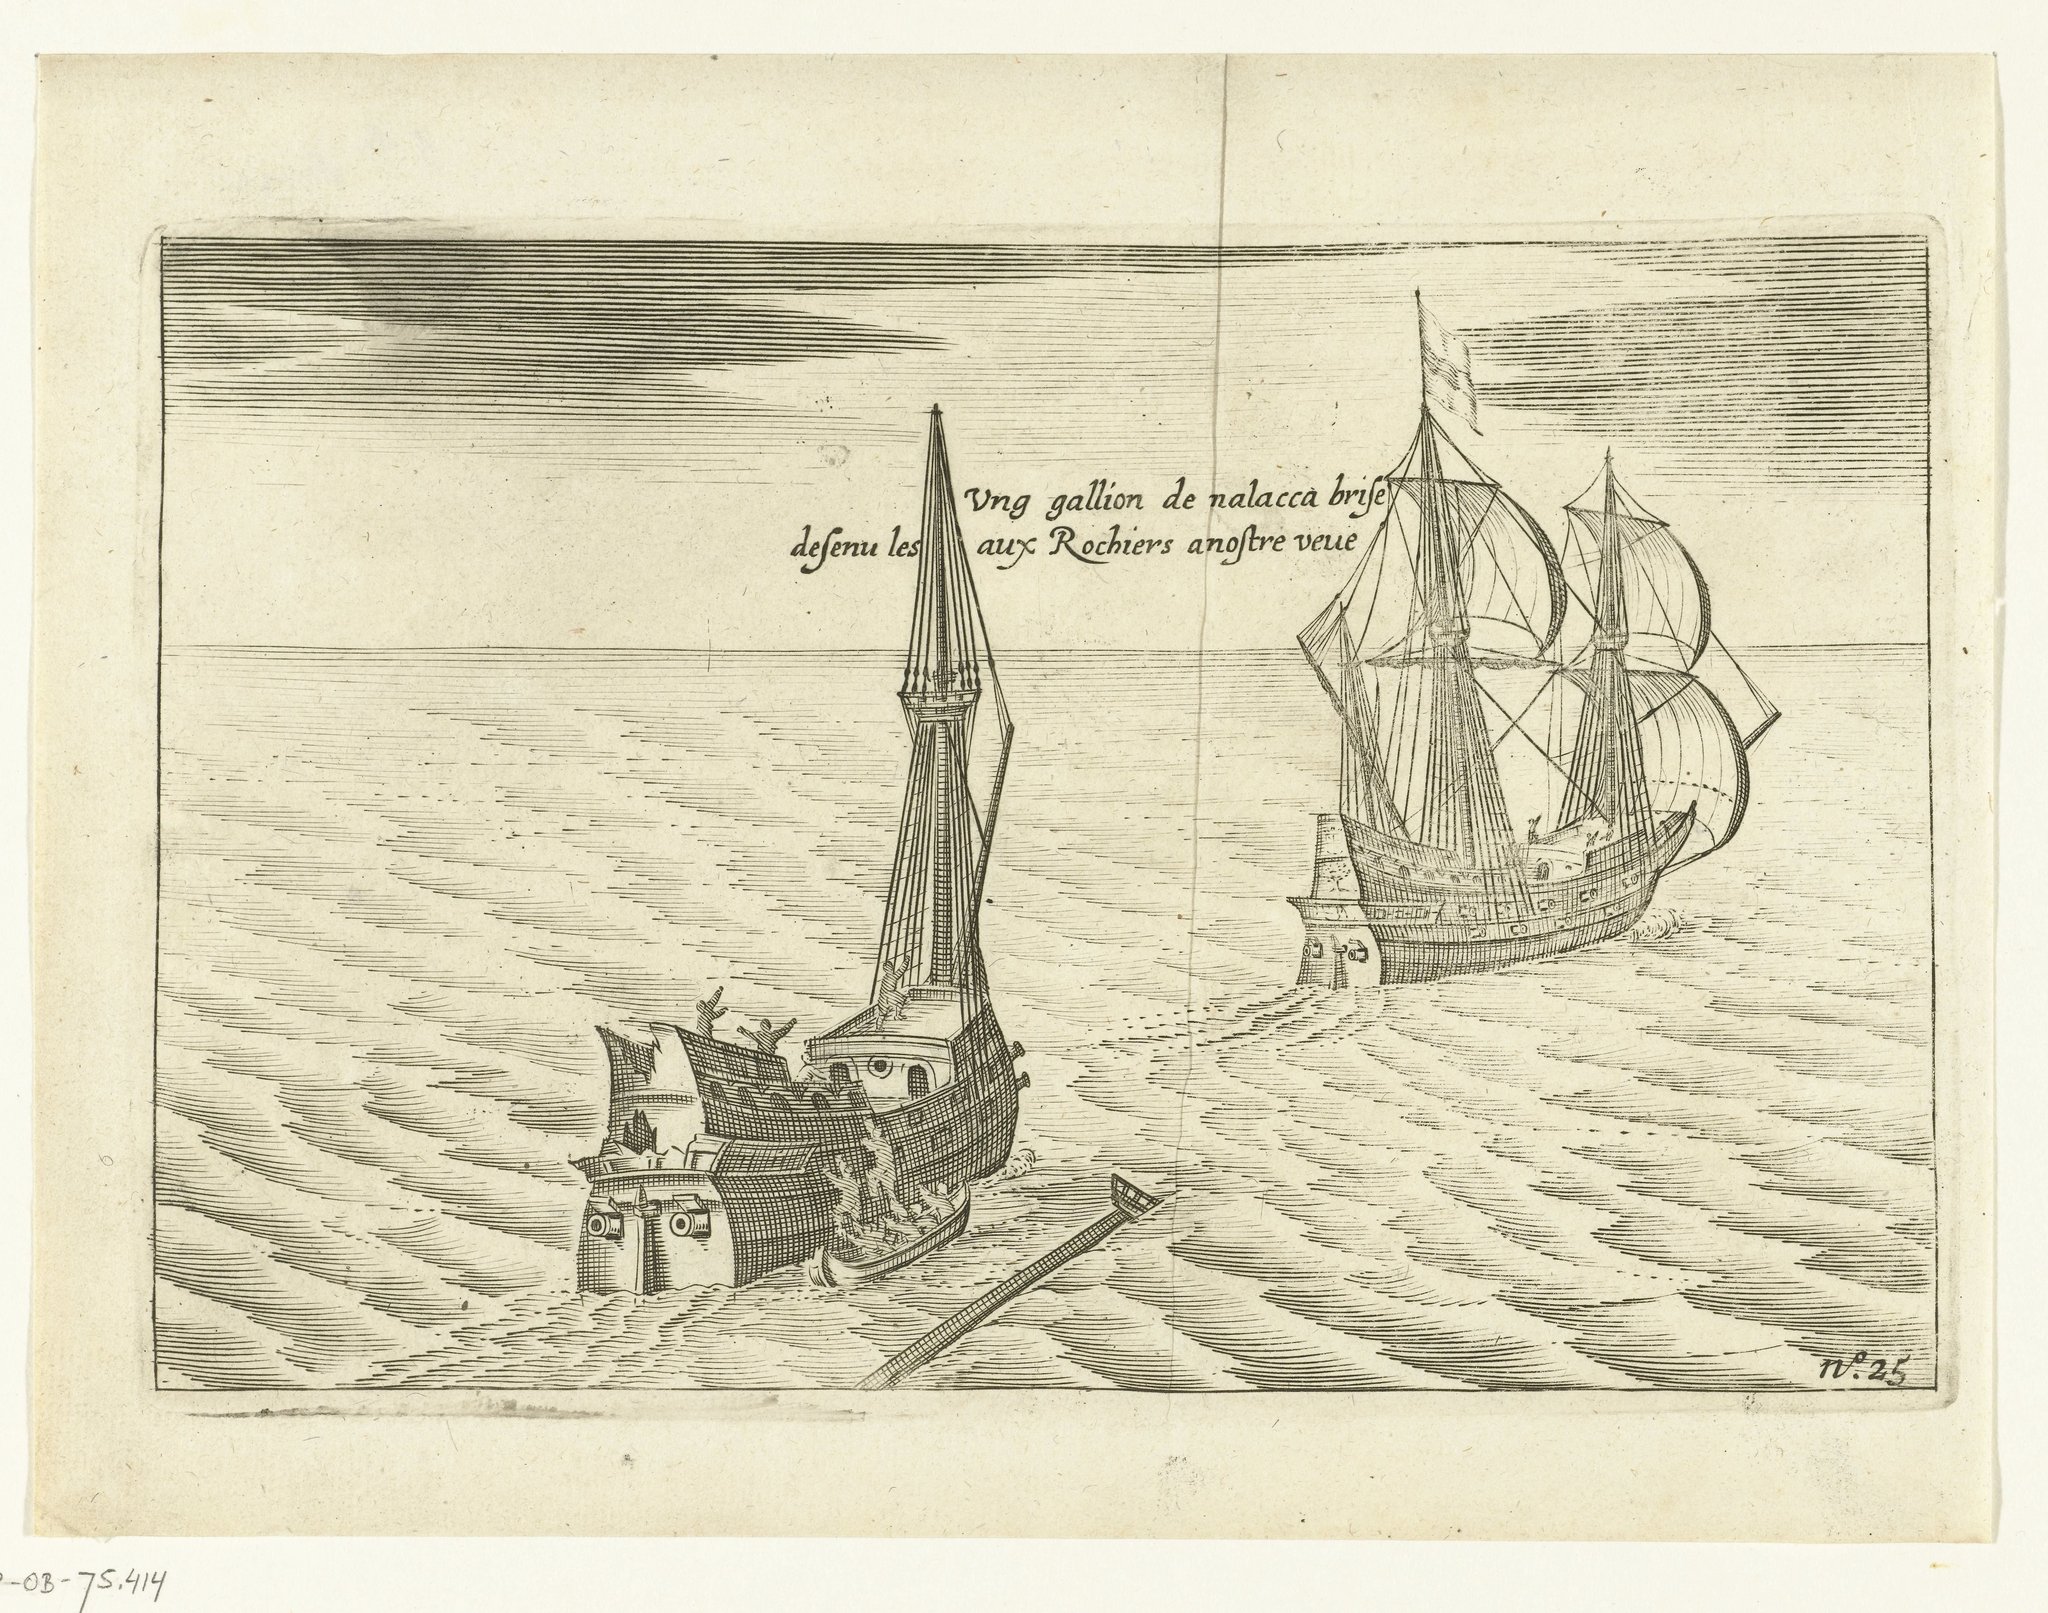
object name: print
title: Ontmoeting met een gestrand Portugees schip, 1601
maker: Anonymous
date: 1601-1602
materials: paper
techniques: engraving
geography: northern netherlands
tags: utrecht, shipwreck, landscapes in tropical and sub-tropical regions, exploration, expedition, voyage of discovery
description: Gebruikt als illustratie eerst in: O. van Noort, Beschryvinghe vande voyagie om den geheelen werelt cloot, ghedaen door Olivier van Noort van Utrecht. ... door de Strate Magellanes, ... langs de custen van Cica, Chili ende Peru, om den gantschen aerden cloot, ende door de Molucques wederom thuys te comen. : Te zeyl gegaen van Rotterdam ... 1598. Ende ... weder ghekeert ... 1601. Daer in dat vertelt wort zyne wonderlijcke avontueren, Jan van Waesberge (II) te Rotterdam en Cornelis Claes te Amsterdam 1602. Later gebruikt in: Oost-Indische ende West-Indische voyagien, Michiel Colijn, Amsterdam 1619 en in deze staat eerst gebruikt in: Beschrijvinge van de Schipvaerd by de Hollanders ghedaen onder 't beleydt ende Generaelschap van Olivier van Noort, door de Straet of Engte van Magallanes, ende voorts de gantsche kloot des Aertbodems om. Opgenomen in: I. Commelin, Begin ende voortgangh, van de Vereenighde Nederlantsche Geoctroyeerde Oost-Indische Compagnie, J. Janssonius, Amsterdam 1646. Genummerd: 25.